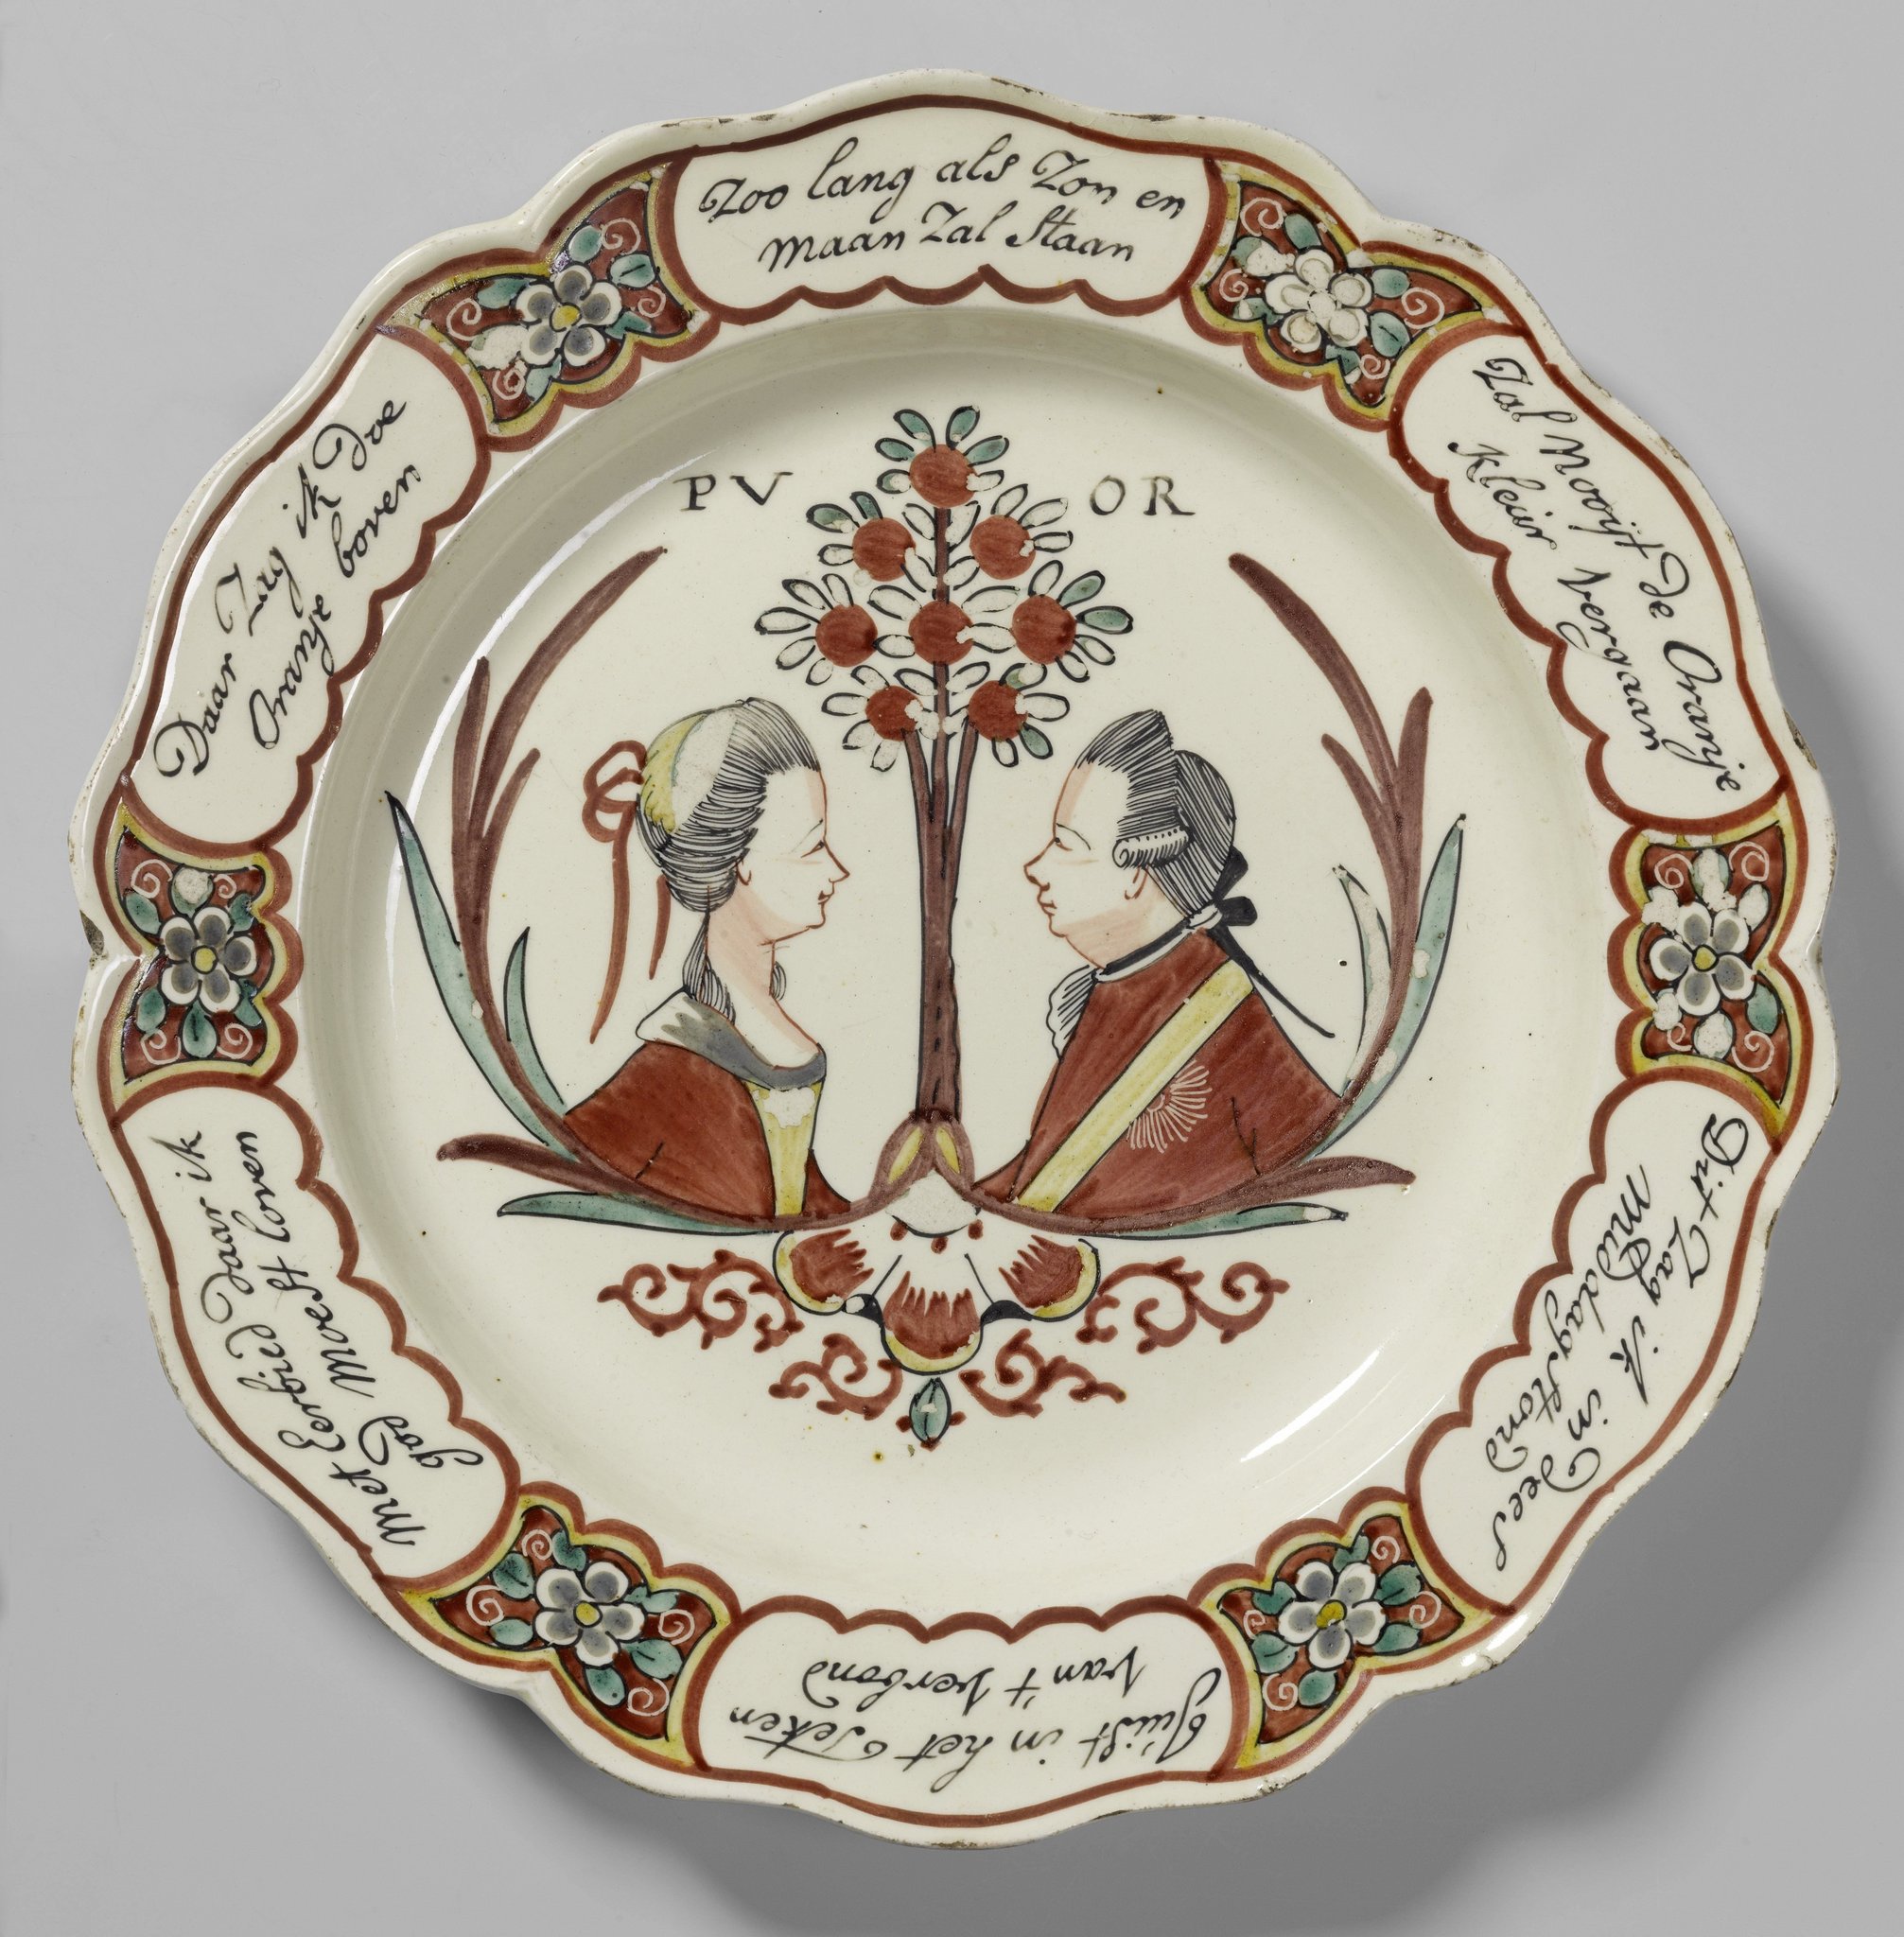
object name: plate dish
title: Plate with an orange tree and portraits of William V and Wilhelmina of Prussia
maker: Anonymous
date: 1780-1795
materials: creamware, paint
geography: leeds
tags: the hague, william v (prince of orange), berlin, painter, draughtsman, wilhelmina of prussia (princess of orange)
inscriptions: inscription: ‘Zoo lang als Zon en maan Zal Staan; Zal Nooijt de Oranje kleur vergaan; Dit Zag ik in dees middagstond; Juist in het Teken van't verbond; met Eerbied daar ik god moest loven; Daar Zag ik doe Oranje boven.’, monogram: ‘PV OR’